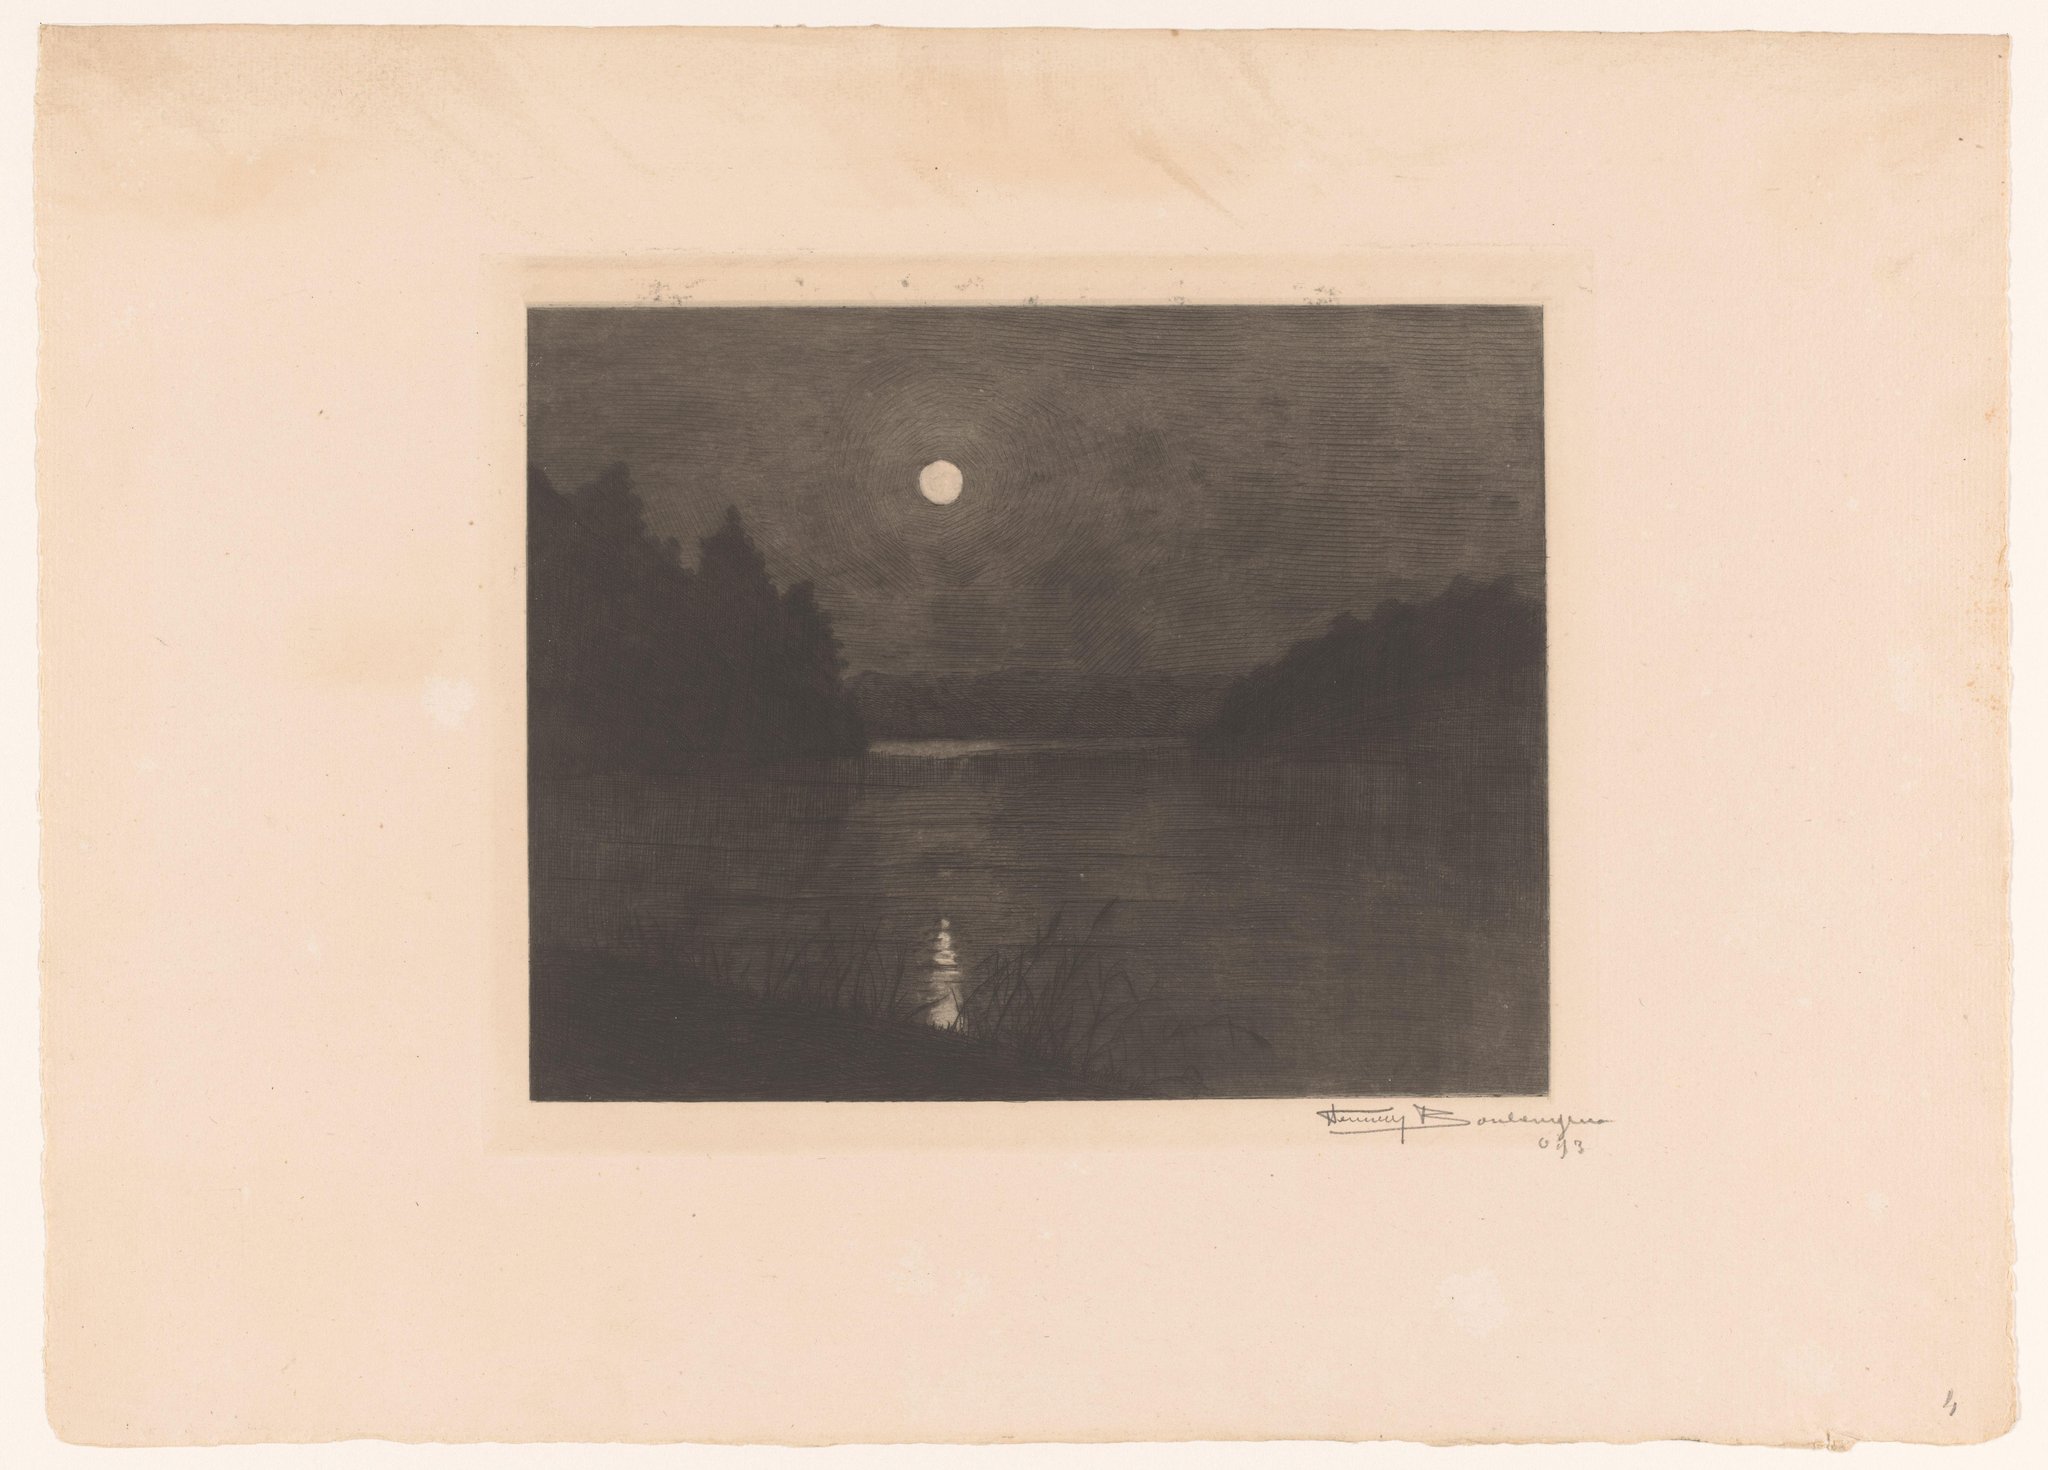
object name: print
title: Maneschijn op een meer omringd door bomen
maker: herman boulenger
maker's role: draughtsman, print maker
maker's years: 1871-1913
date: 1893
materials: paper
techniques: drypoint, etching, intaglio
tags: moonlight, lake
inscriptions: collector's mark: Lugt 2228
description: Sterfdatum kunstenaar onbekend. Derhalve is voor bepaling van de rechten van dit object de vervaardigingsdatum aangehouden.